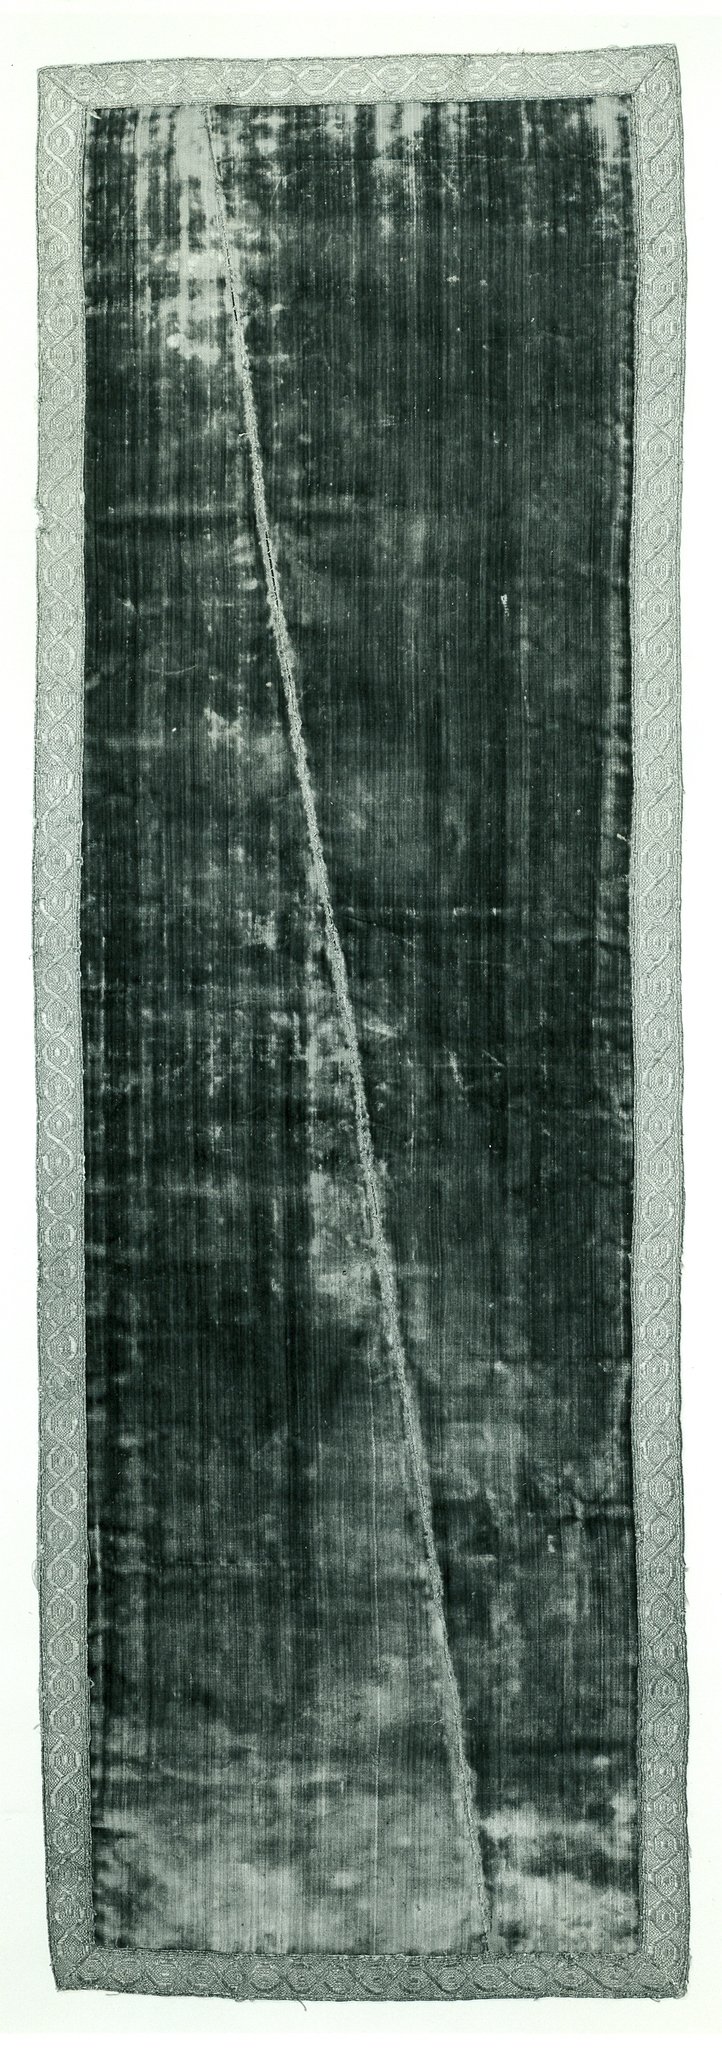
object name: textile cover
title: Cover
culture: italian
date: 1701-1800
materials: linen, metal, silk